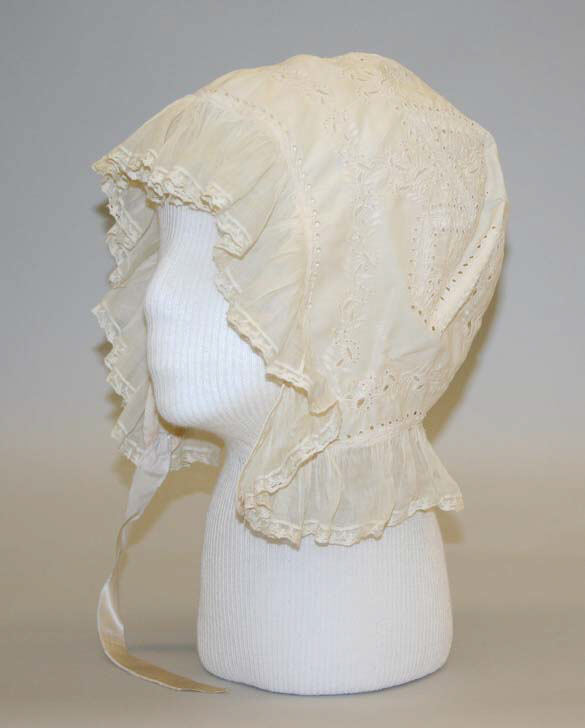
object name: morning cap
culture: american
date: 1812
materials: cotton, silk